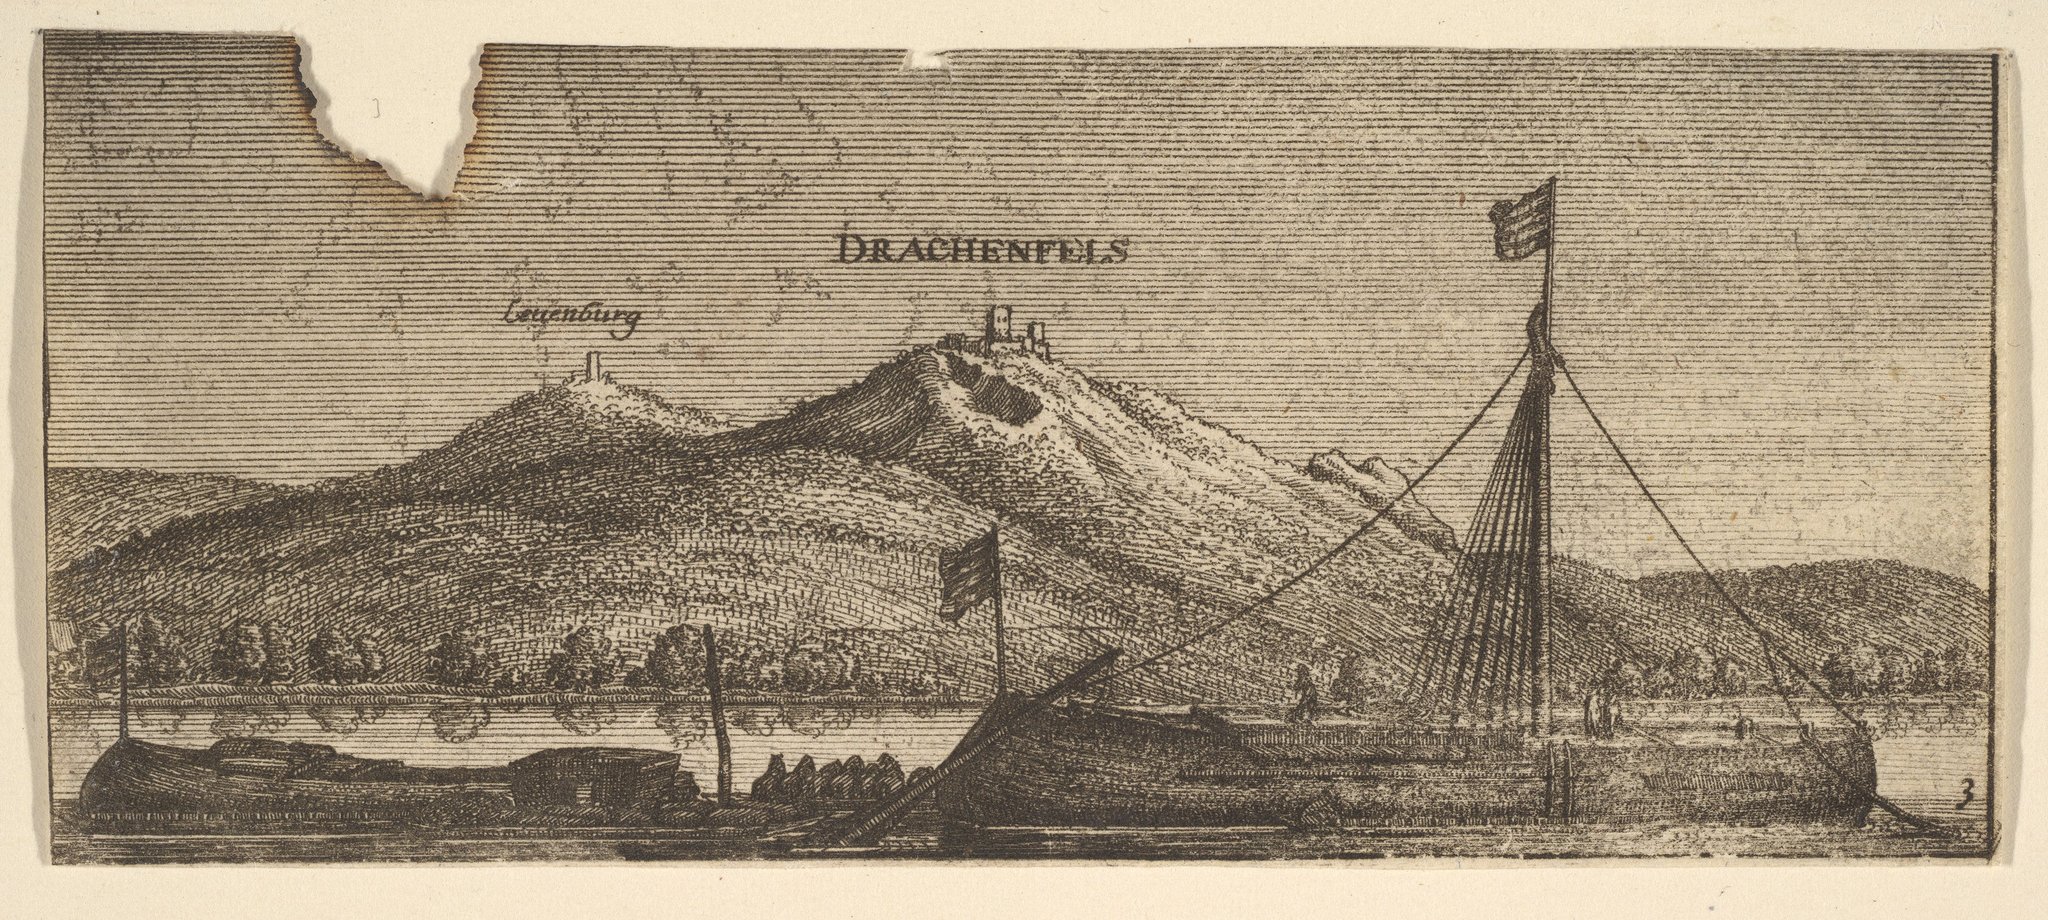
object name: print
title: Drachenfels and Lowenburg, from "German Views"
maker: wenceslaus hollar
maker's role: artist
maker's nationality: bohemian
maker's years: 1607-1677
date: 1652-1677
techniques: etching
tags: hills,ships